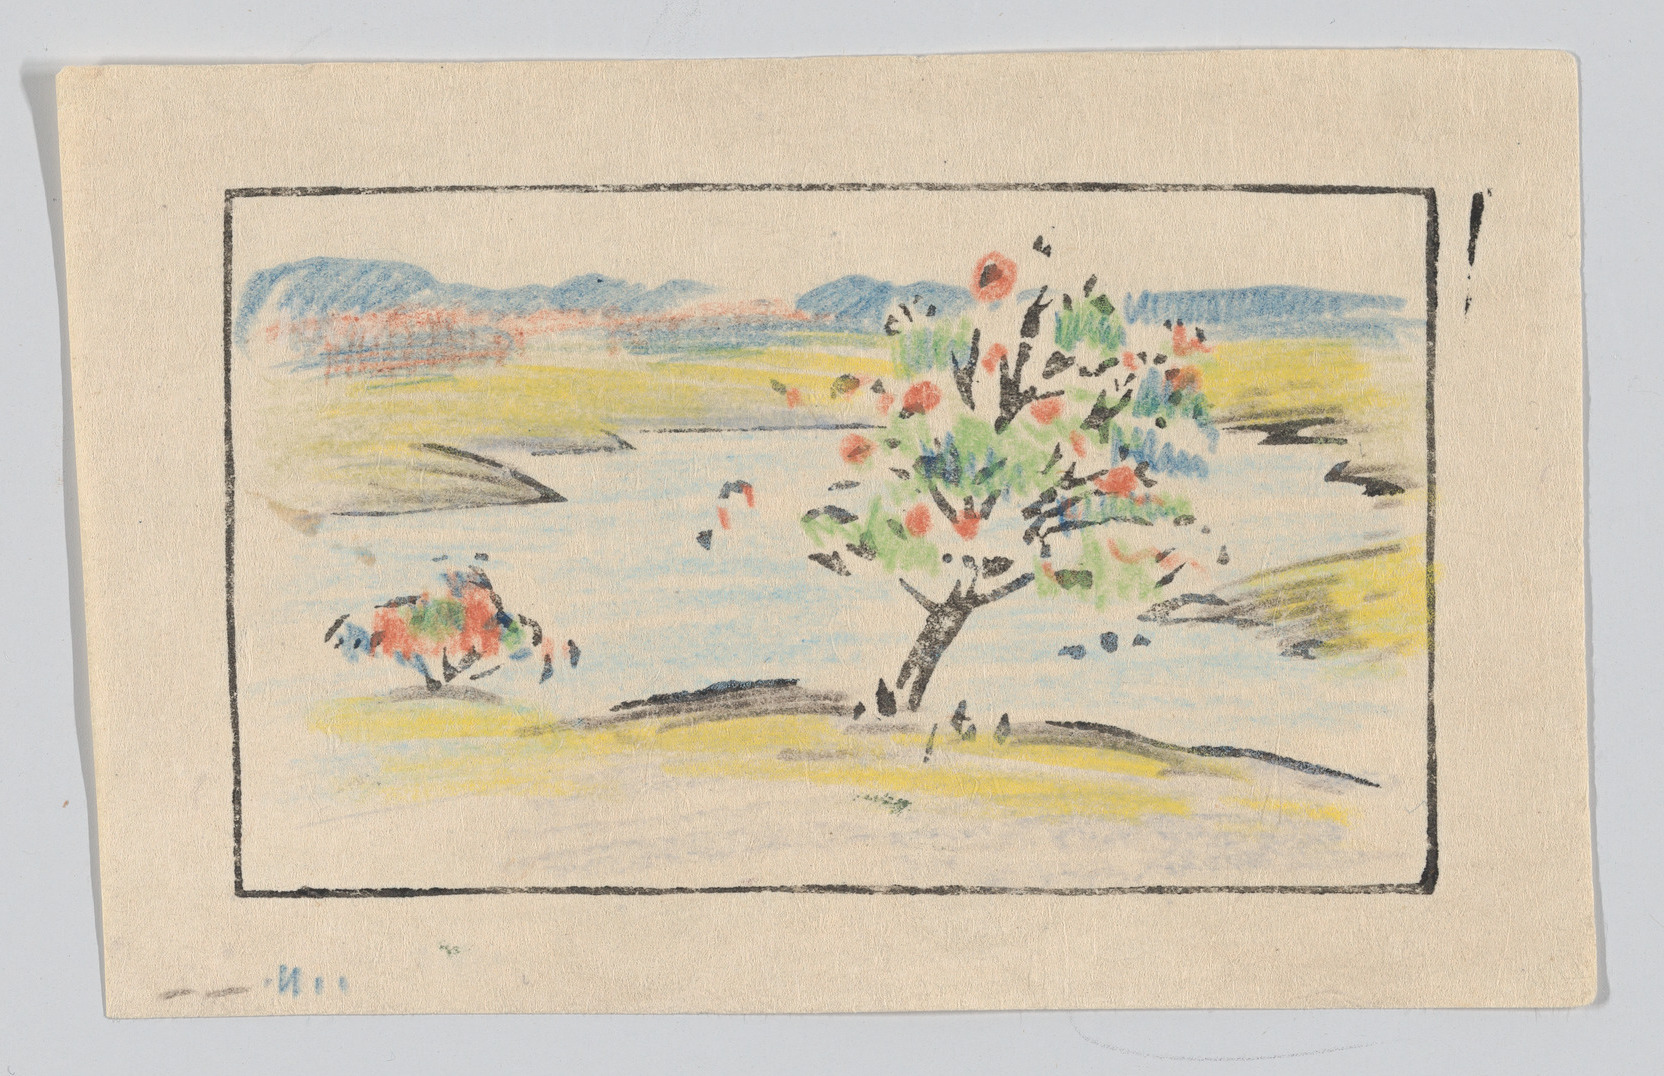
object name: woodcut, print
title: Nabby's Point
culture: american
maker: arthur wesley dow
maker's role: artist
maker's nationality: american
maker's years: 1857-1922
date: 1913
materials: paper, pencil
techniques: woodcut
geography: united states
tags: landscapes,trees